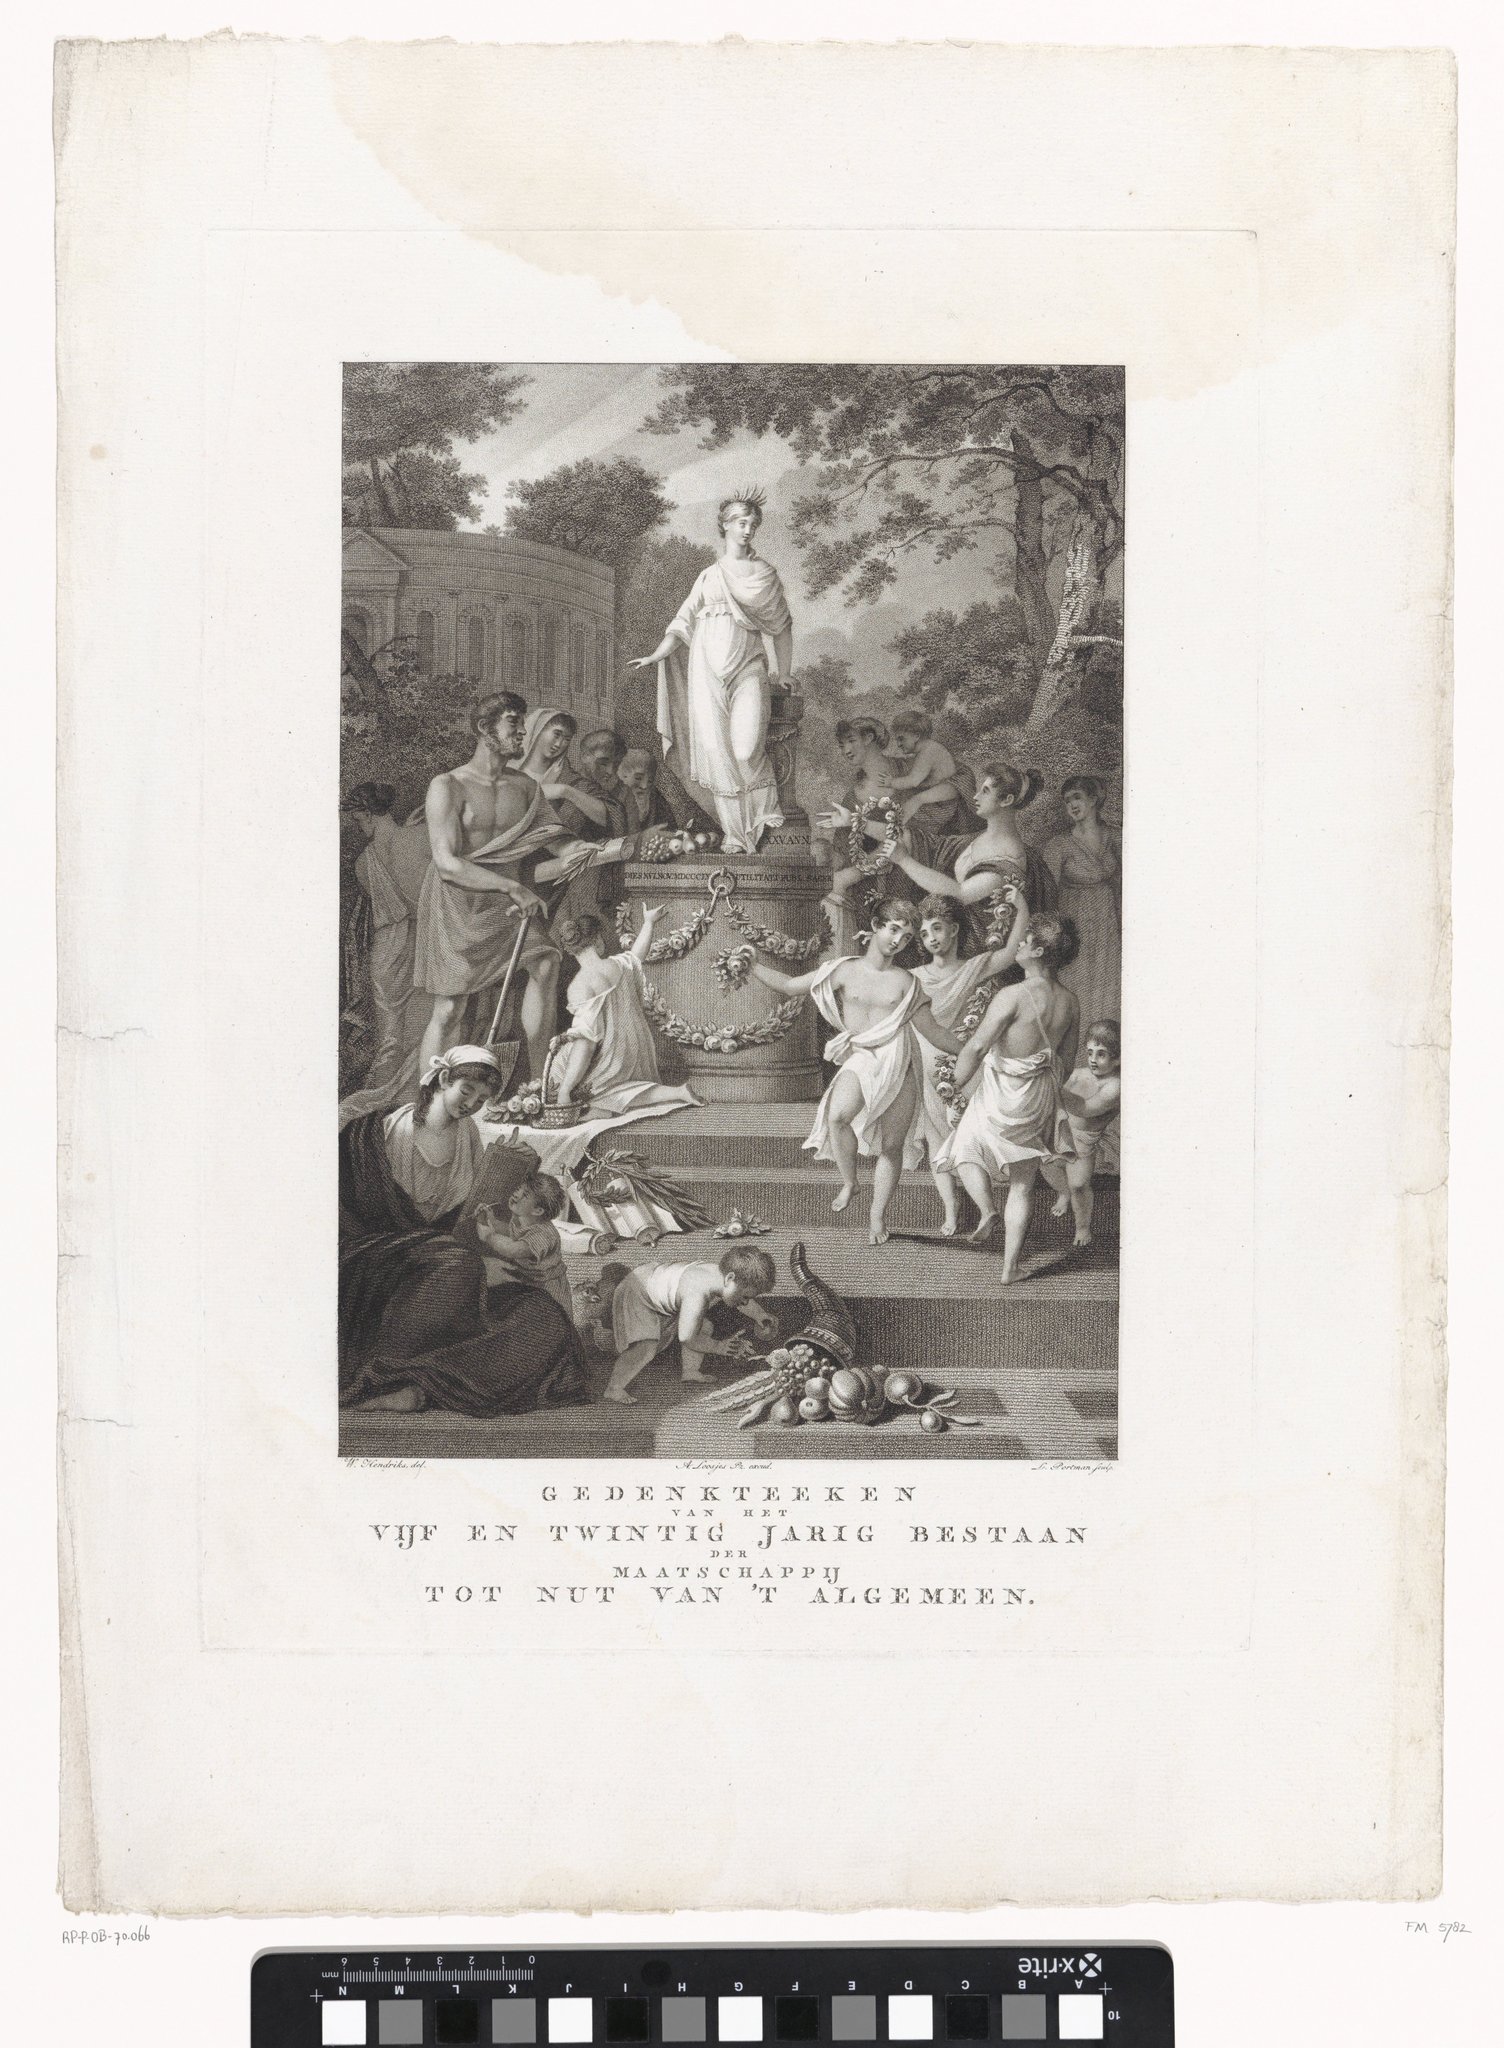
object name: print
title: Gedenkteeken van het Vijf en Twintig Jarig Bestaan der Maatschappij tot Nut van 't Algemeen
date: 1809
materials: paper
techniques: stippled etching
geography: amsterdam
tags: charity, 'caritas'; 'carità' (ripa) ~ one of the three theological virtues, symbolic representations, allegories and emblems ~ education; 'ammaestramento', dottrina', 'educatione', 'istitutione' (ripa) (+ variant)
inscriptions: collector's mark: Lugt 2228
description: Allegorische voorstelling met de personificatie van de Maatschappij op een met guirlandes versierde sokkel. Rondom het beeld diverse allegorische figuren die haar geschenken brengen. Eén van hen biedt haar een bloemenkrans aan. Kinderen dansen in een kring voor de sokkel. Links op de voorgrond Liefde. Een van de kinderen reikt naar de vruchten uit de hoorn des overvloeds (het kind plukt reeds de vruchten van de stichting van de Maatschappij).